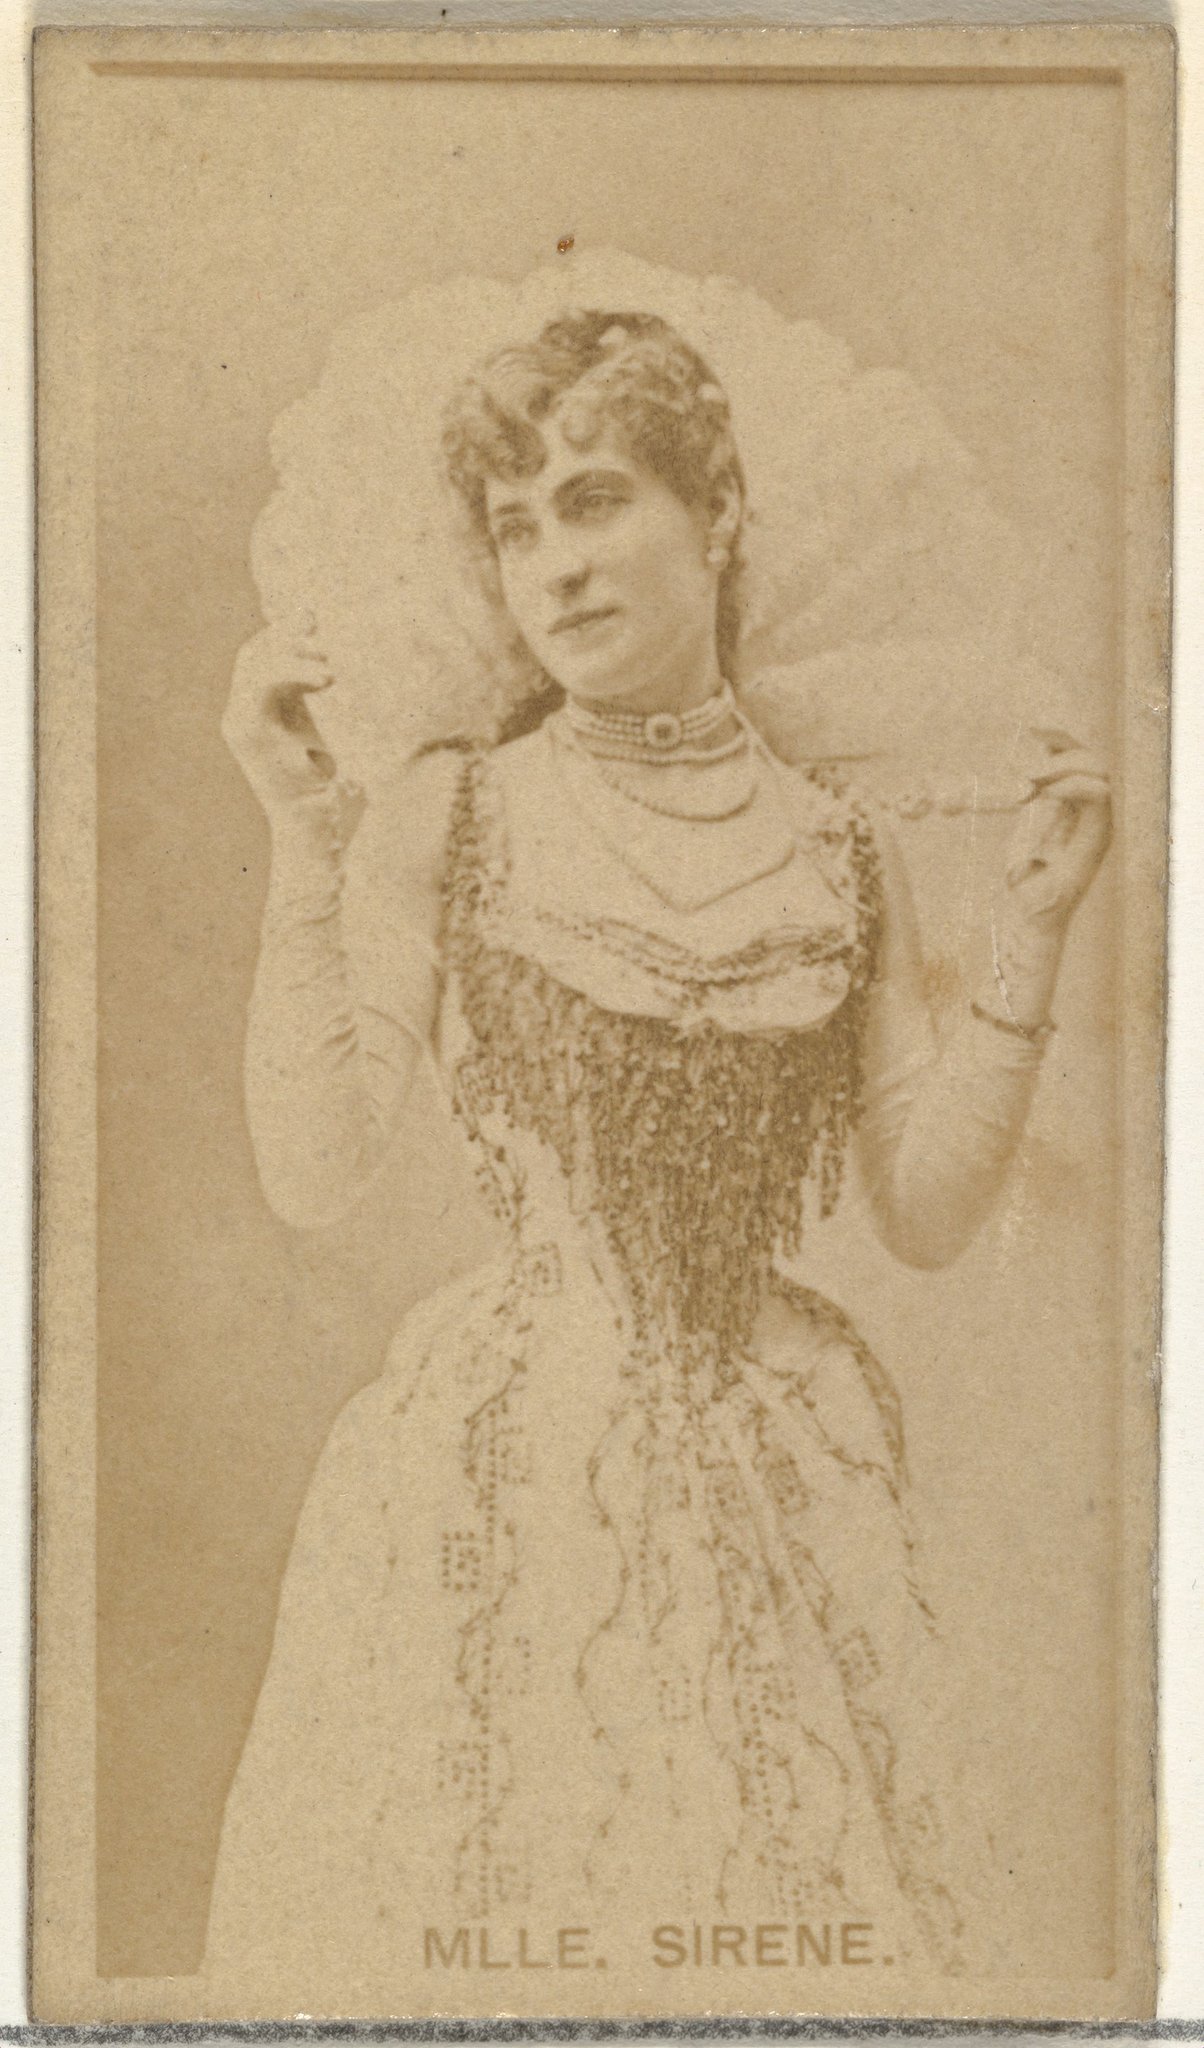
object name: photograph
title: Mlle. Sirene, from the Actors and Actresses series (N145-8) issued by Duke Sons & Co. to promote Duke Cigarettes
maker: w. duke, sons & co.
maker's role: publisher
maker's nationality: american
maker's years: 1870-1920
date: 1891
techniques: albumen silver print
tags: portraits,women,actresses